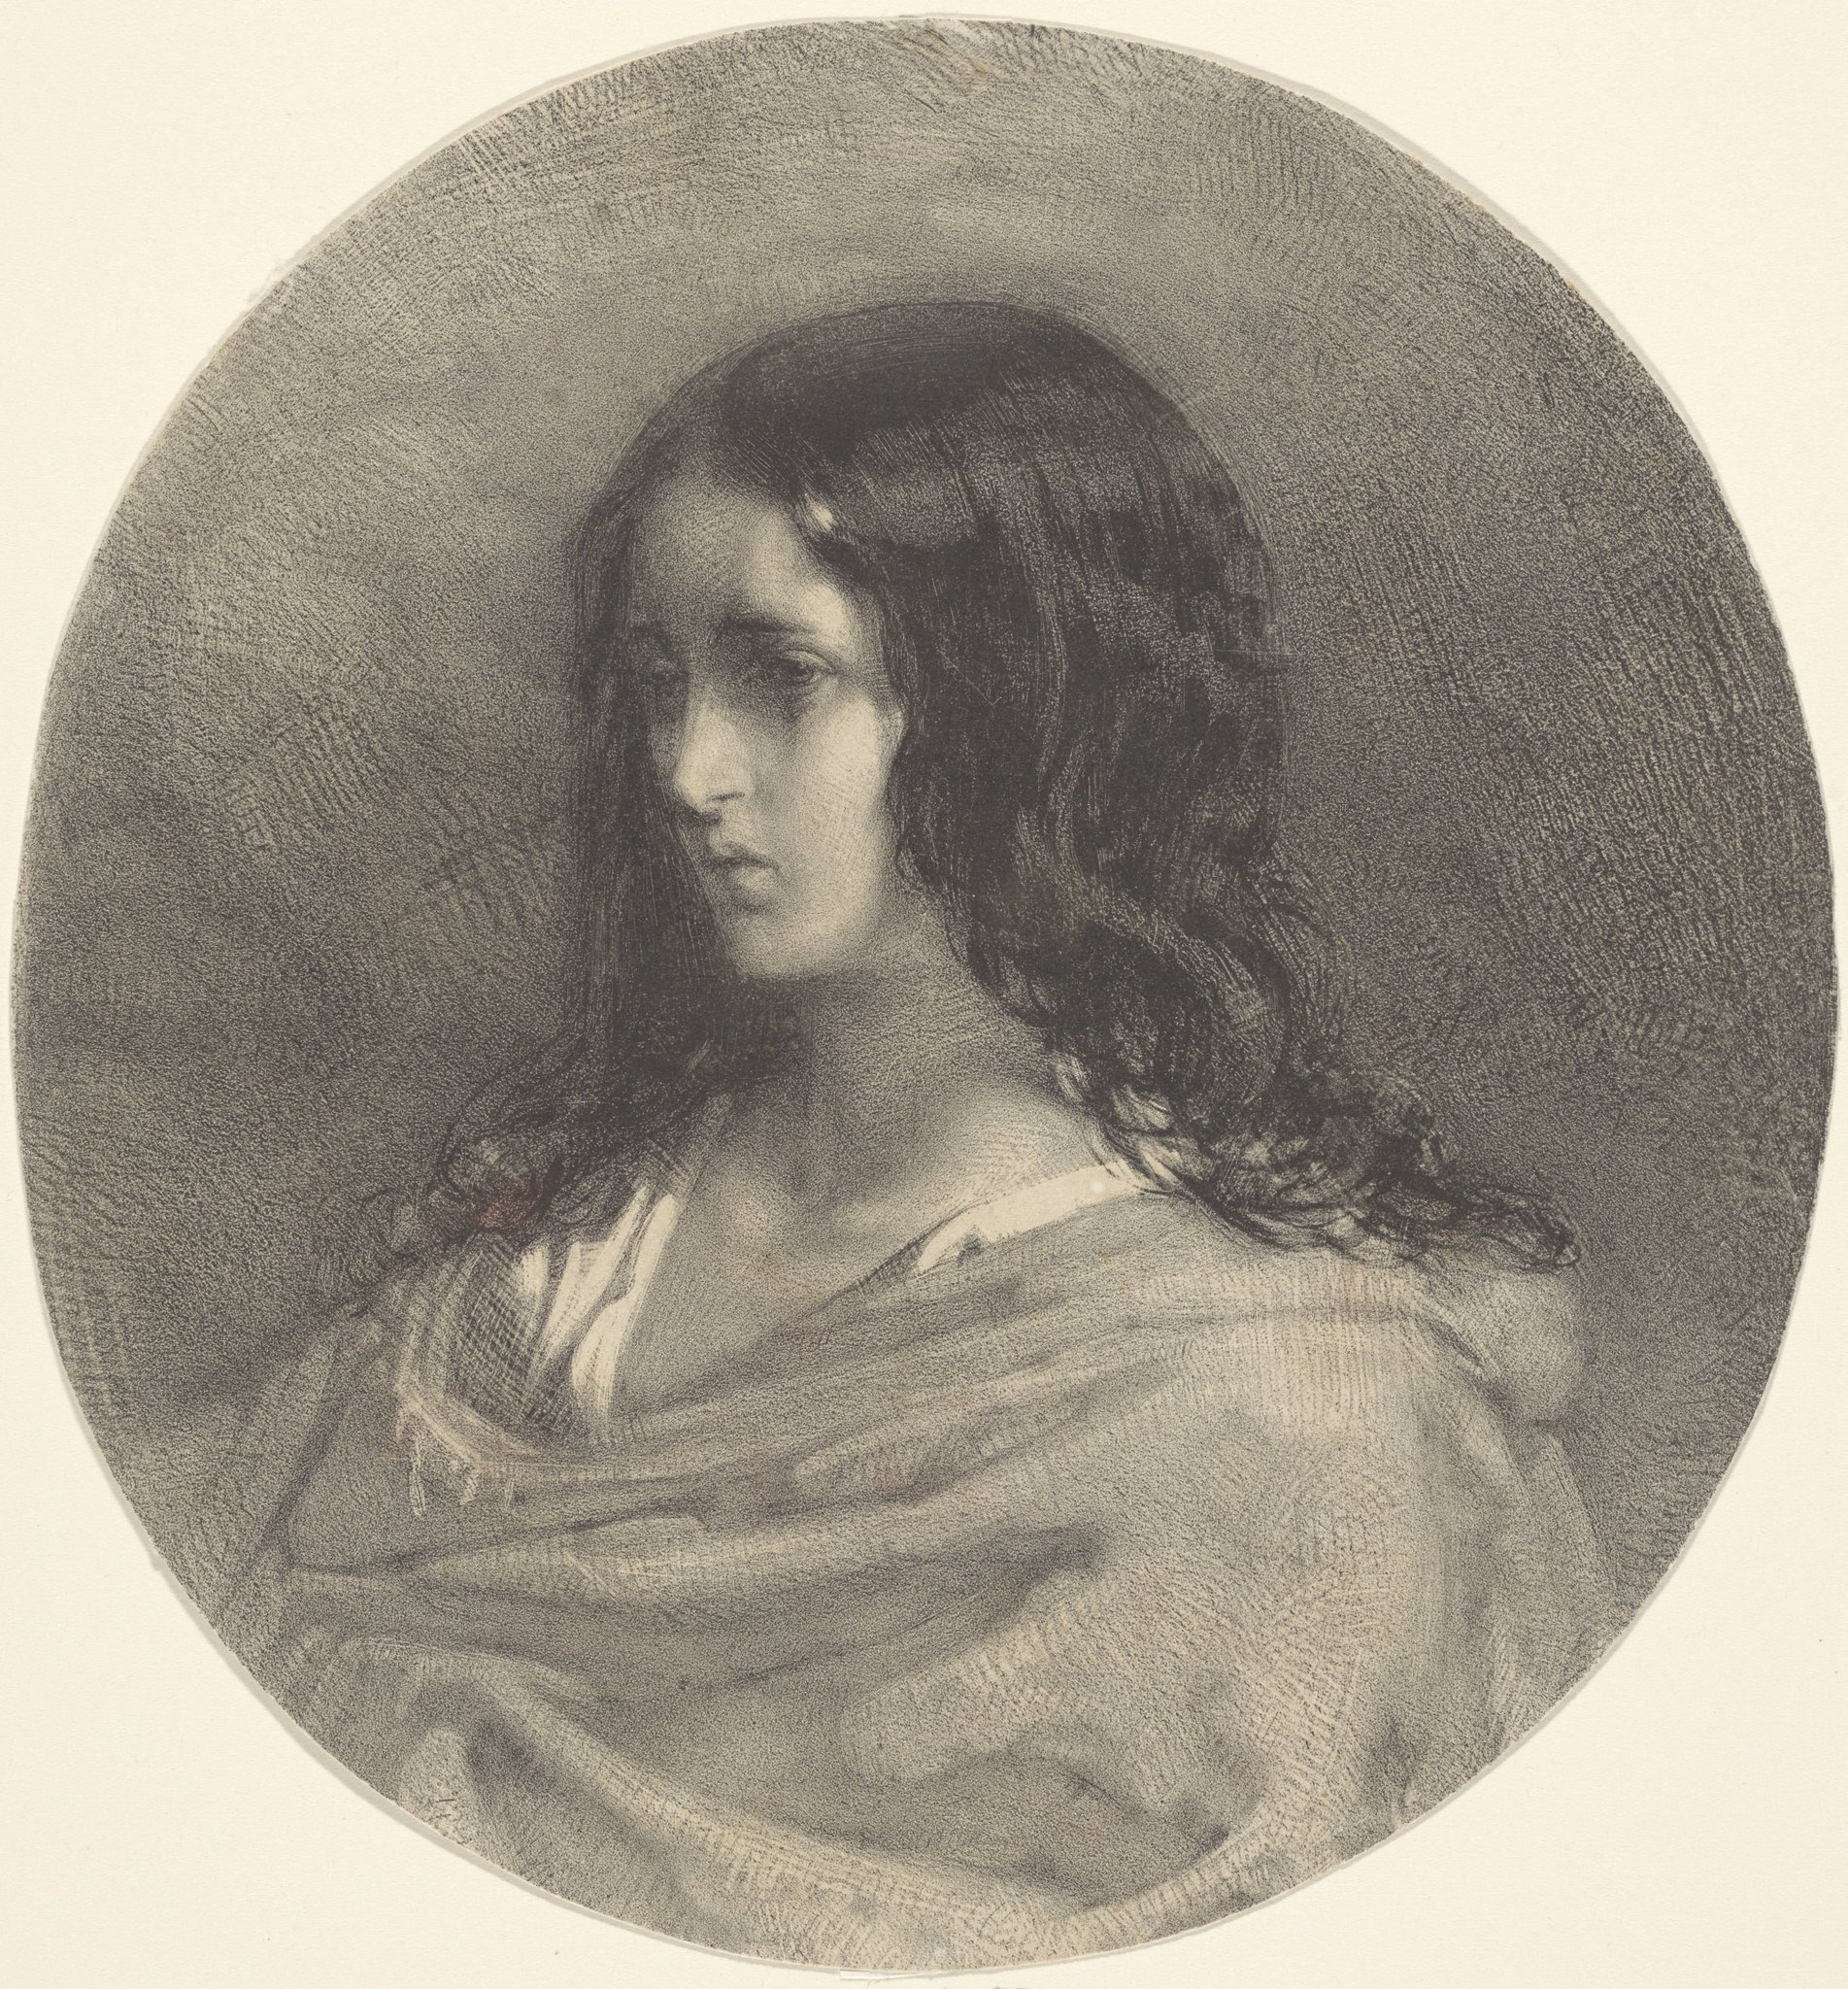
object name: print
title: Portret van een onbekend meisje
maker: august allebé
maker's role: draughtsman, print maker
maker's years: 1838-1927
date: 1848-1913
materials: paper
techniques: lithograph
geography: amsterdam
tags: adolescent, young woman, maiden, looking downwards, anonymous historical person portrayed - bb - woman